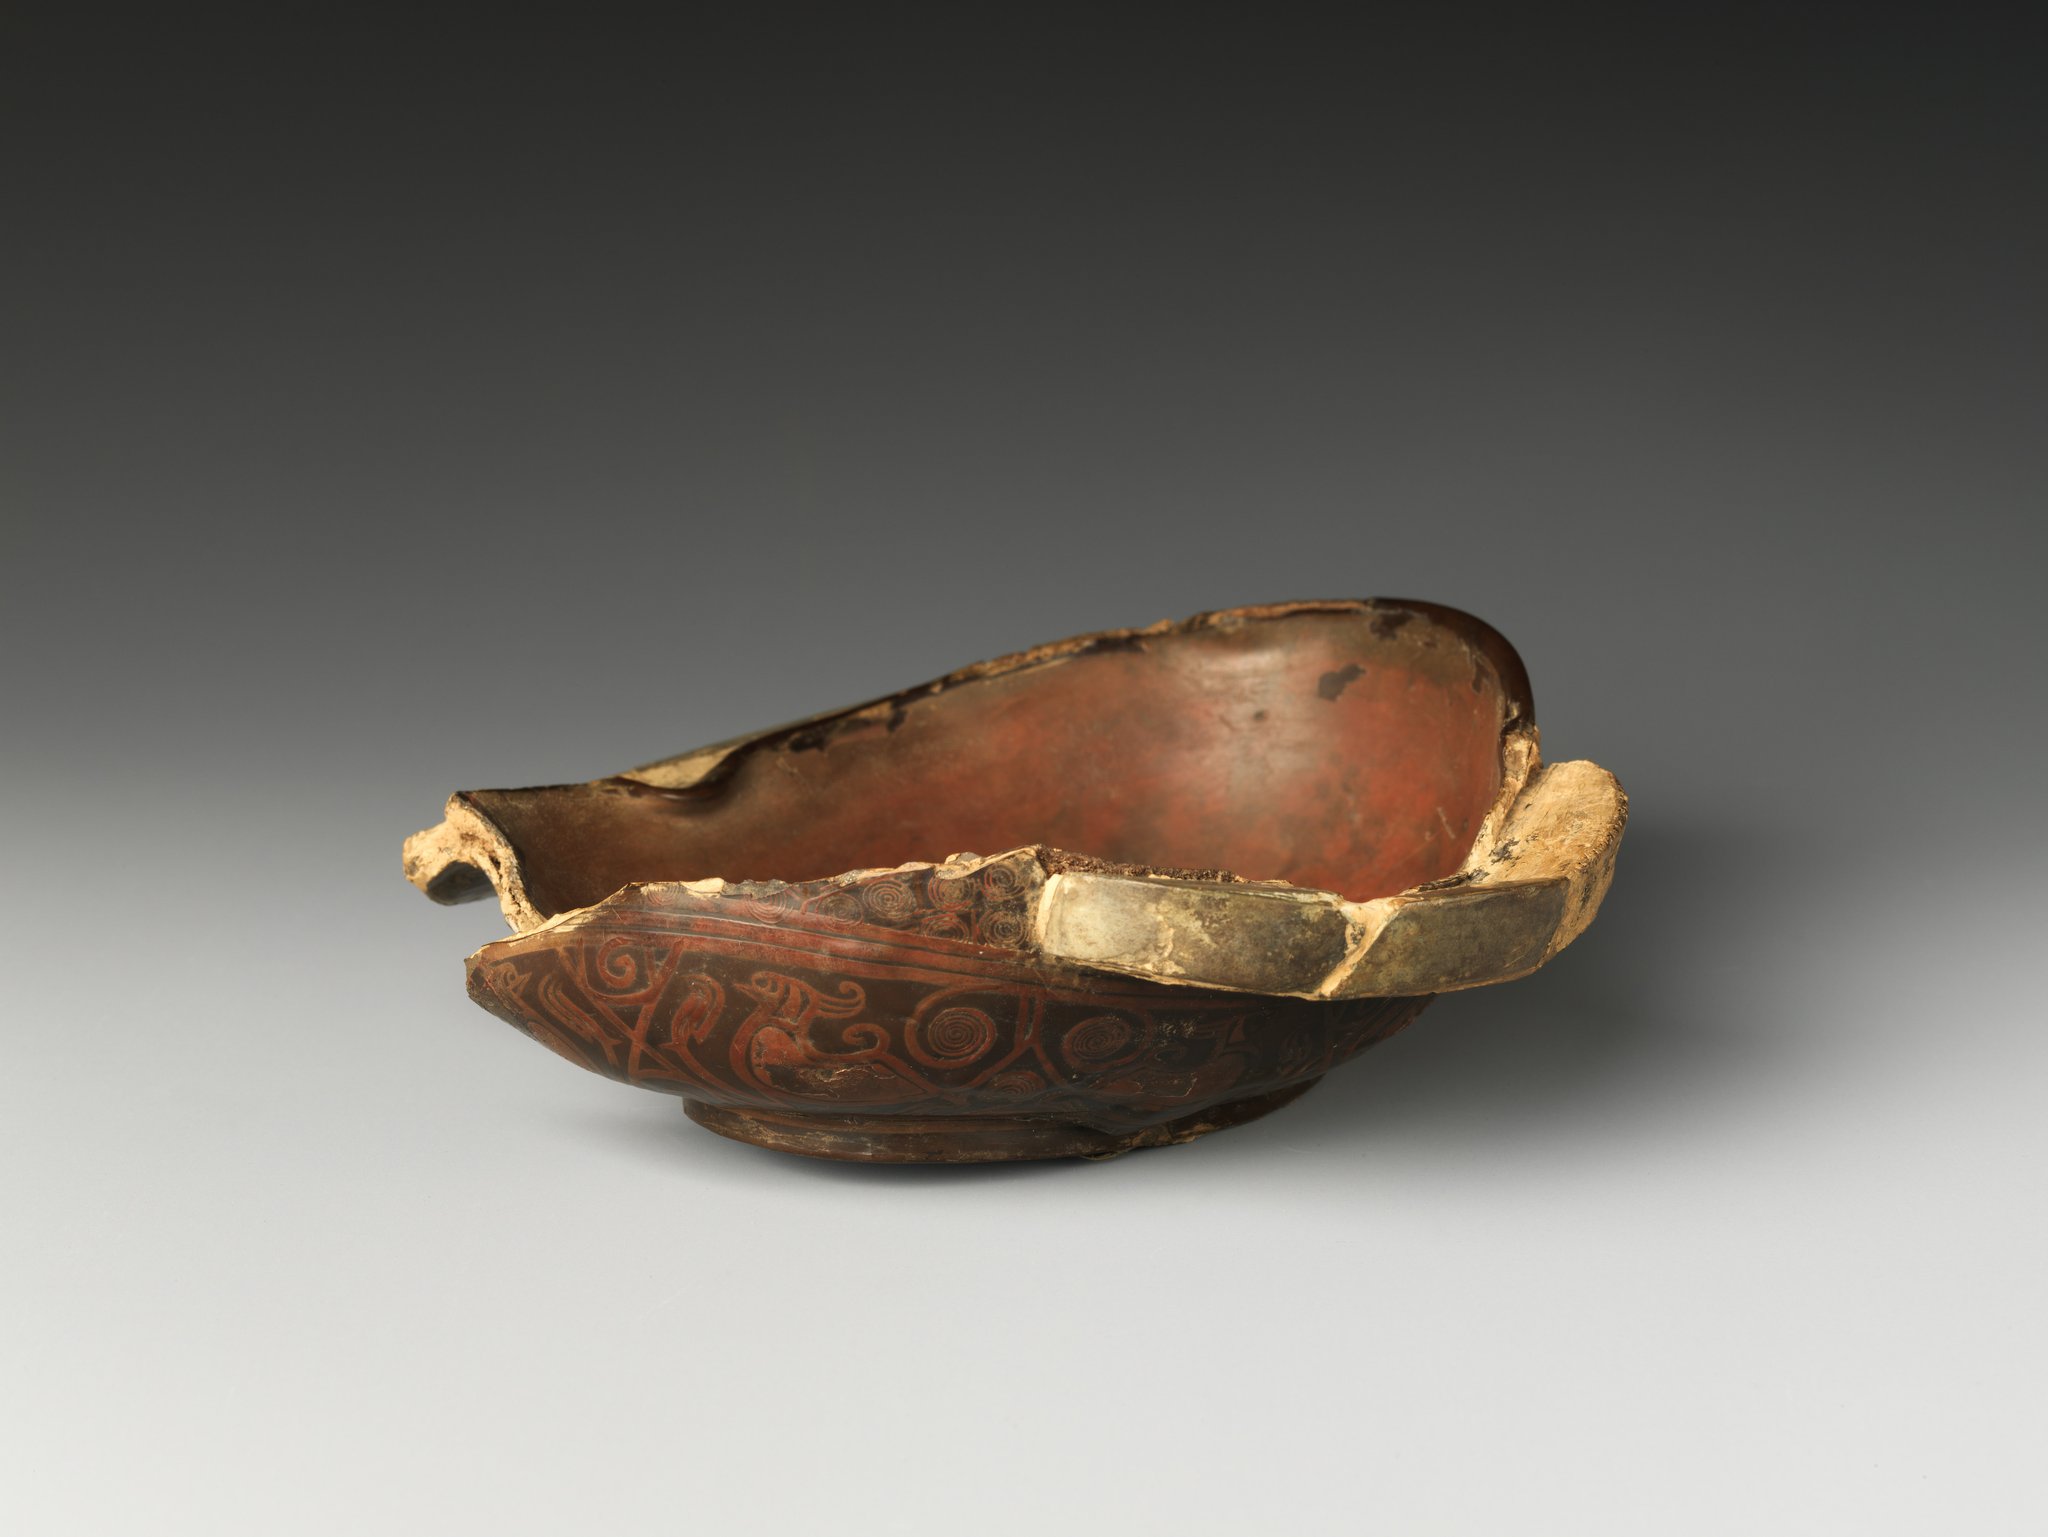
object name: winged cup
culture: chinese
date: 206 BCE-9 CE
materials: lacquer